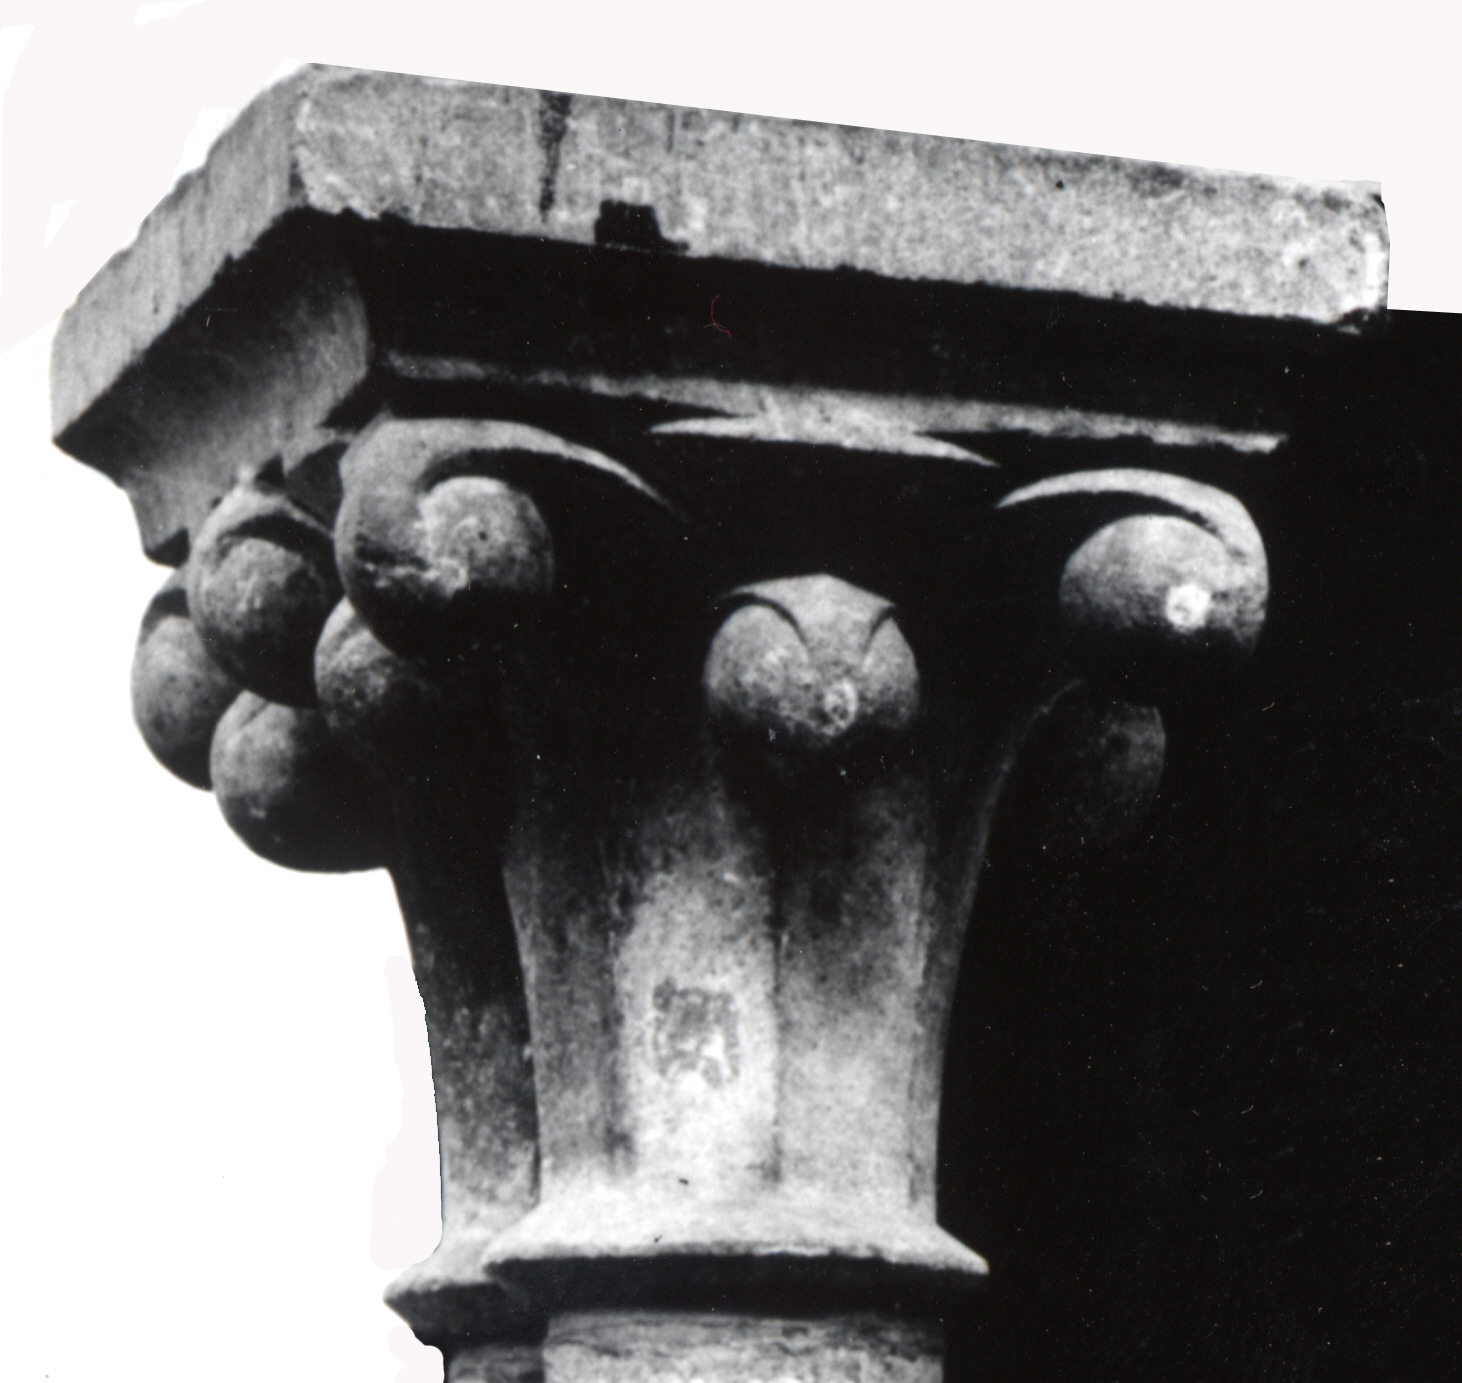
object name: double column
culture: french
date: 1201-1400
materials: marble